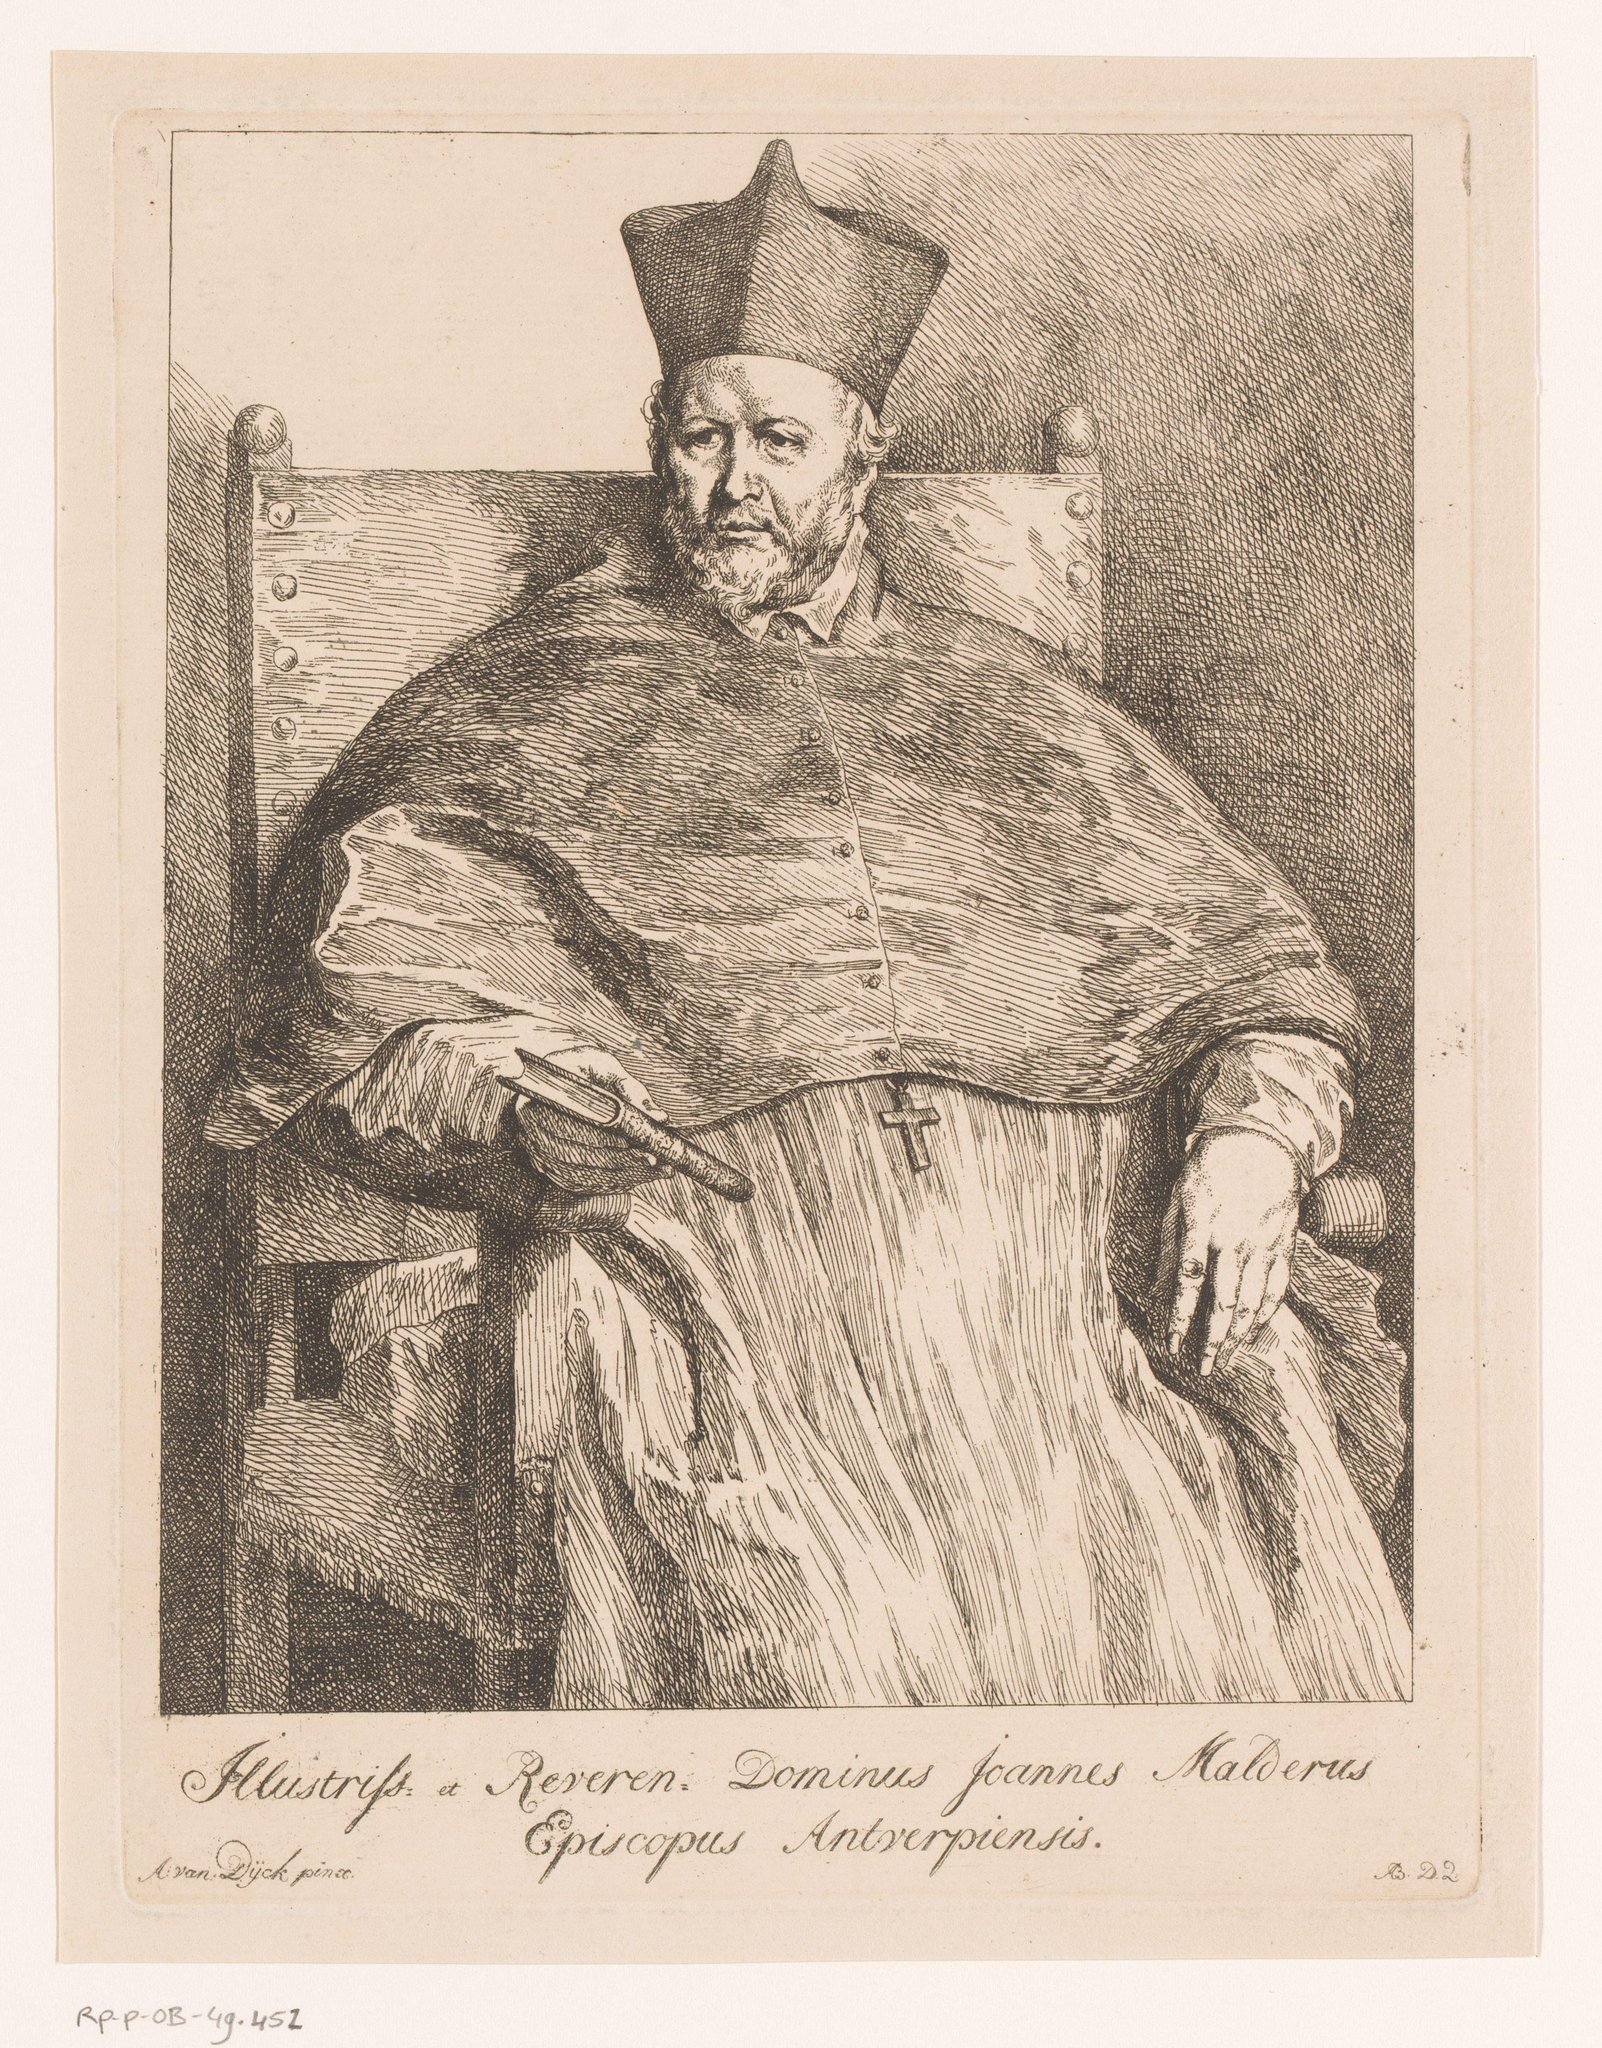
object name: print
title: Portret van bisschop Johannes Malderus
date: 1779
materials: paper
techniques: etching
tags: johannes malderus, armchair, seat, archbishop, bishop, etc. (roman catholic), historical persons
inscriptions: collector's mark: Lugt 240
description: Malderus (geboren Jan van Malderen) was de vijfde bisschop van Antwerpen.